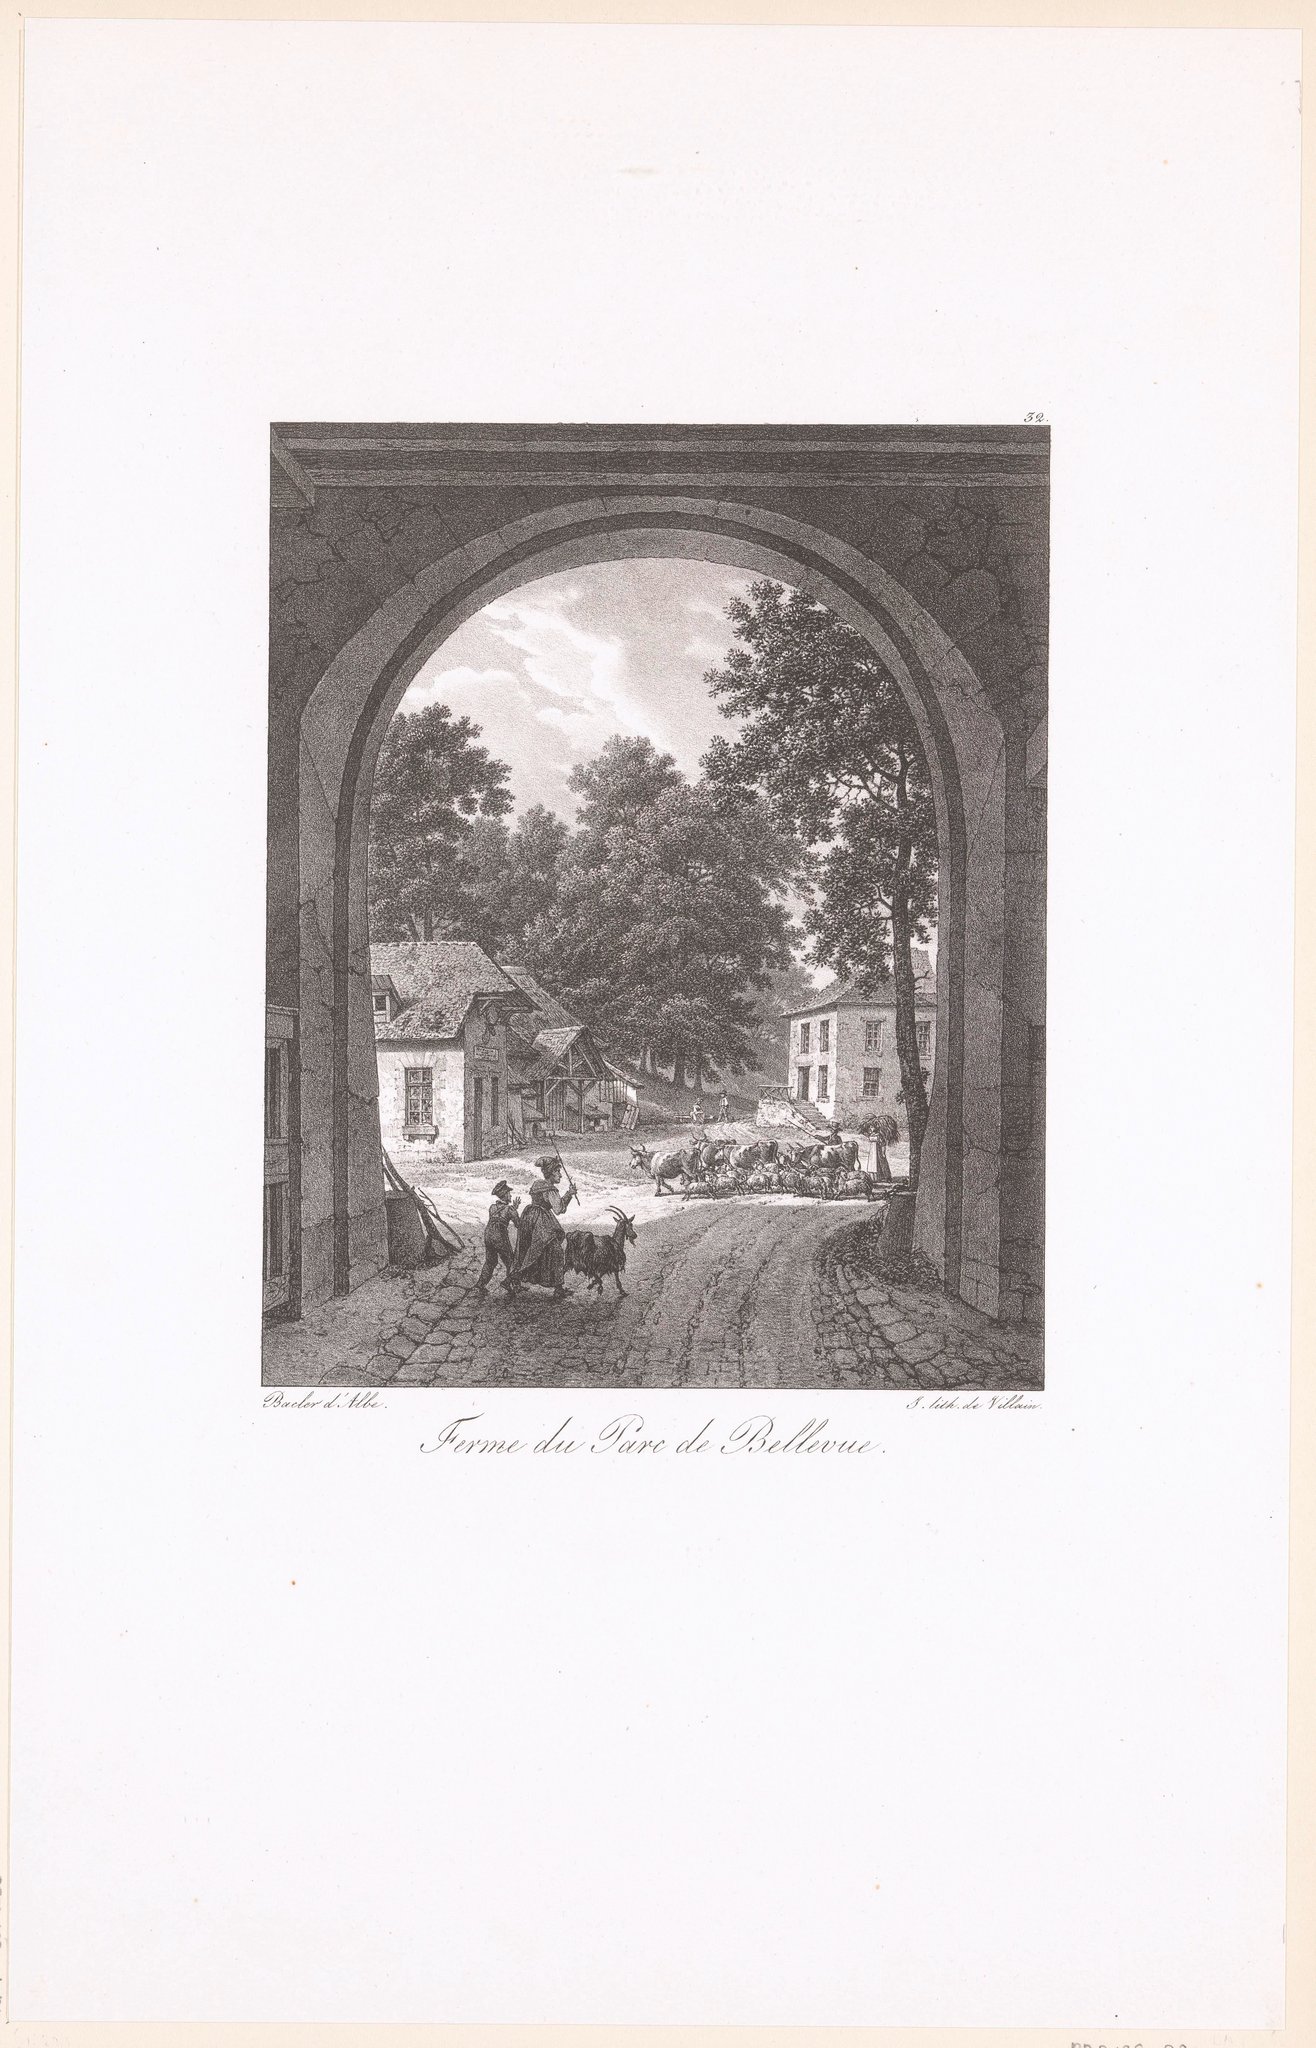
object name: print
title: Pittoreske gezichten op Parijs en omgeving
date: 1822-1824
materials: paper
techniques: lithograph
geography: paris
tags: cattle, road, path, cattle driving, cattle driver, farm (building)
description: Op het pad langs de boerderij worden geiten, schapen en koeien bijeengedreven.